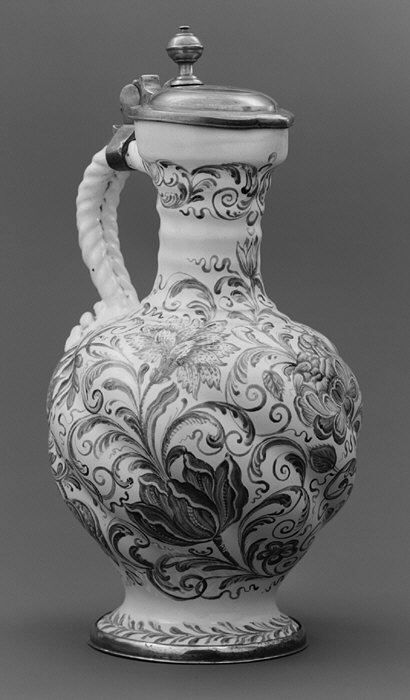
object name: krug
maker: fehr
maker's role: maker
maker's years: 1650-1750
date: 1680-1690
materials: faience, pewter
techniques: glazing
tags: flowers